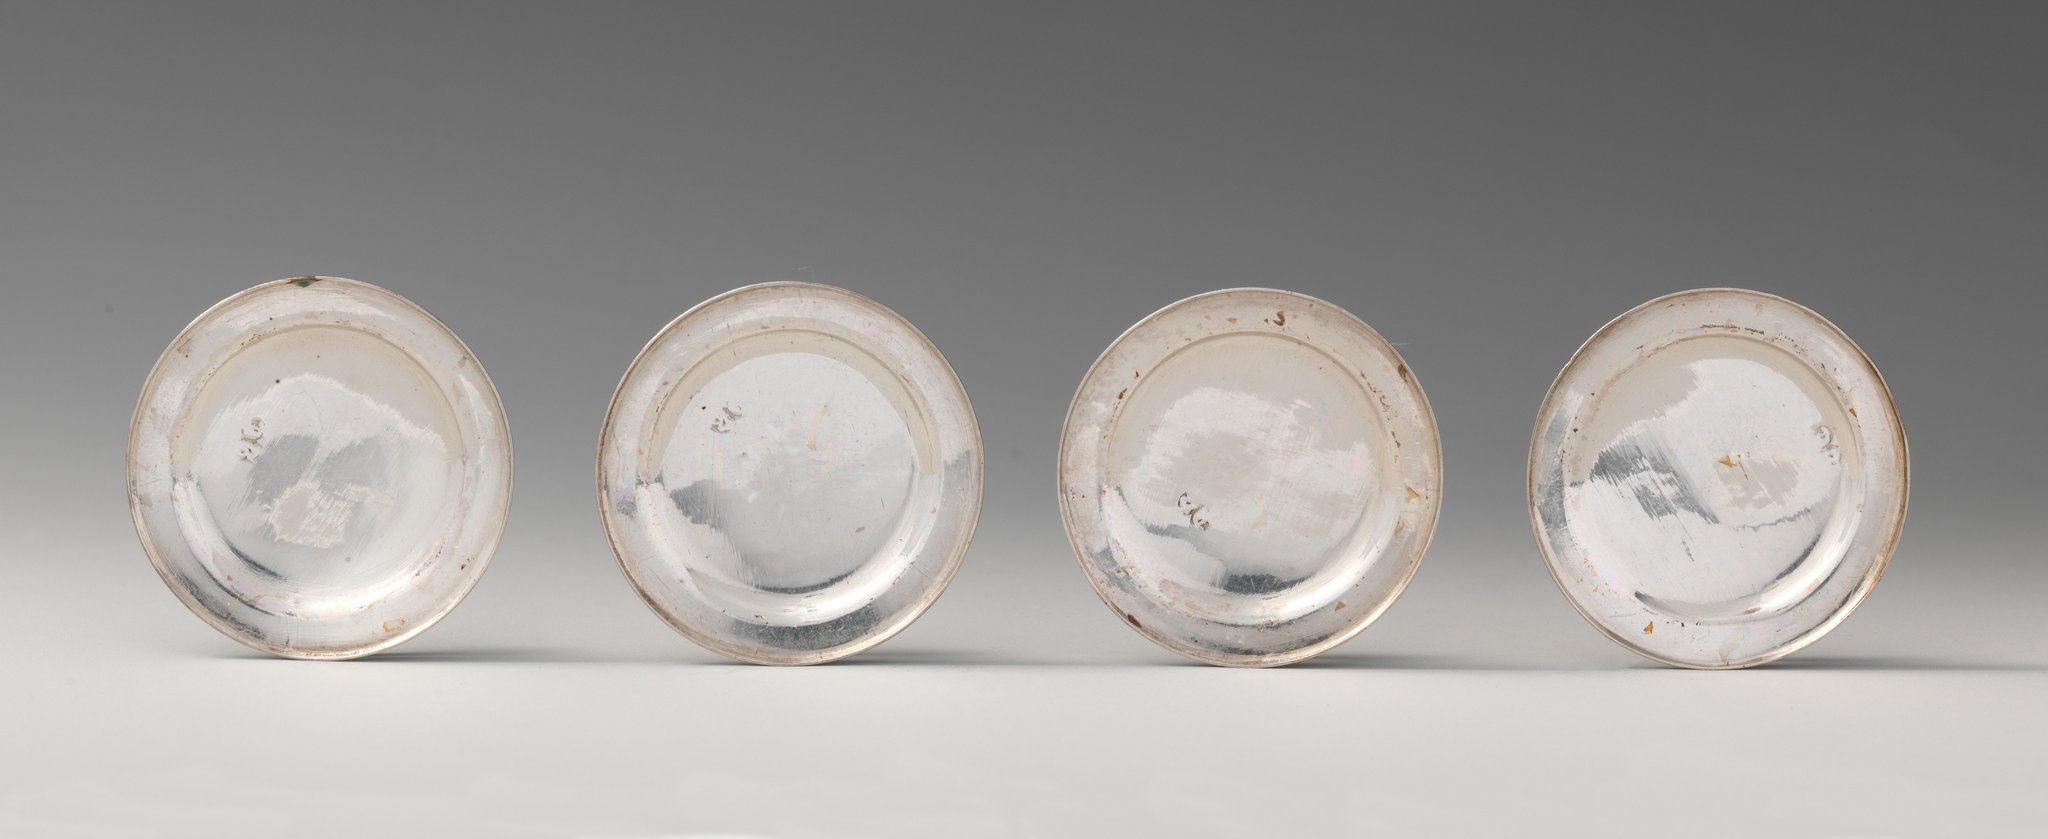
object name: meat plate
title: Set of twelve miniature meat plates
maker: david clayton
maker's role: artist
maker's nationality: british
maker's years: 1659-1719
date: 1720-1730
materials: silver